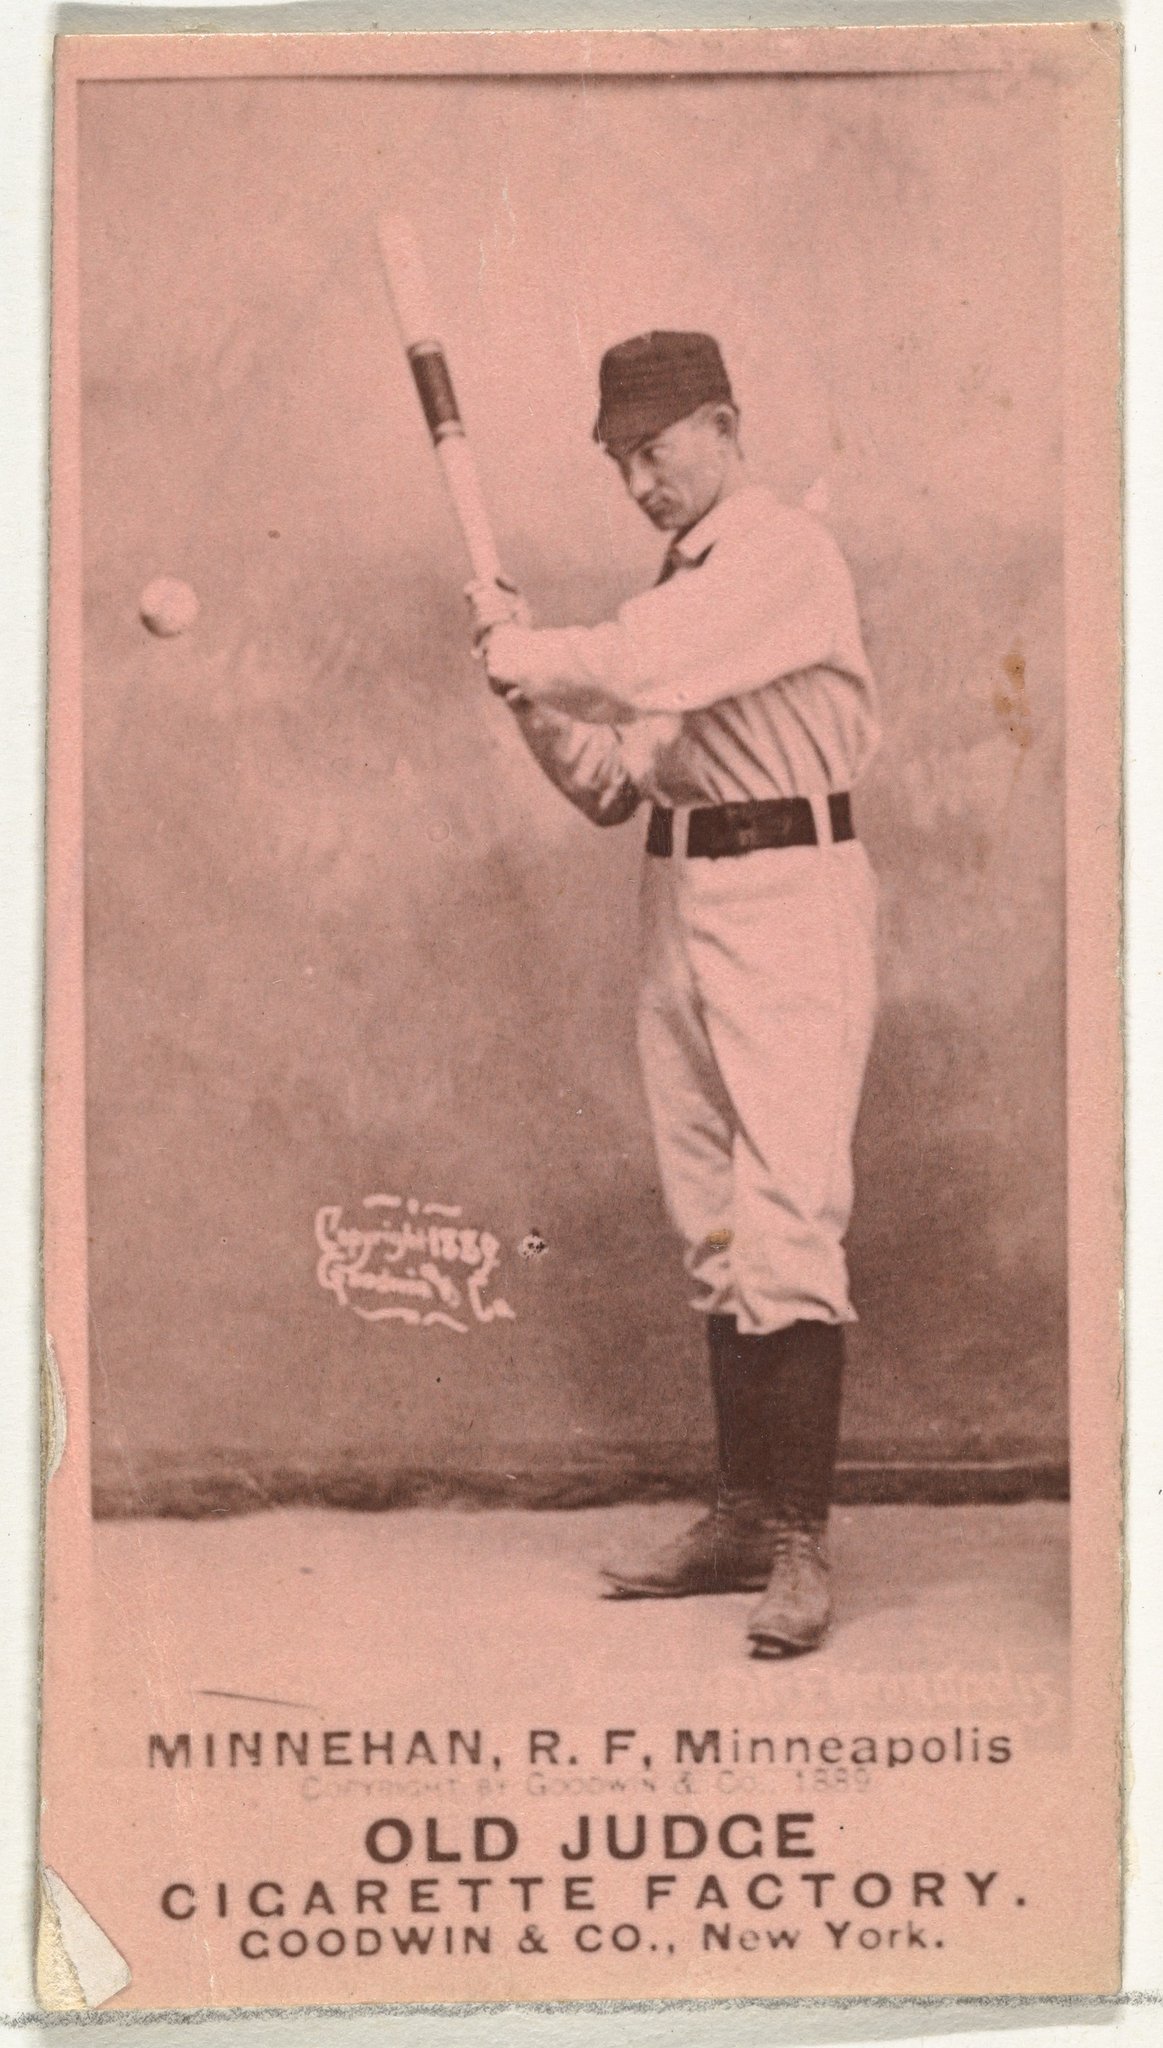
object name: baseball card, photograph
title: Daniel Joseph "Dan" Minnehan, Right Field, Minneapolis, from the Old Judge series (N172) for Old Judge Cigarettes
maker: goodwin & company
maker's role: publisher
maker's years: 1850-1950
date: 1889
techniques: albumen silver print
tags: men,portraits,baseball,athletes